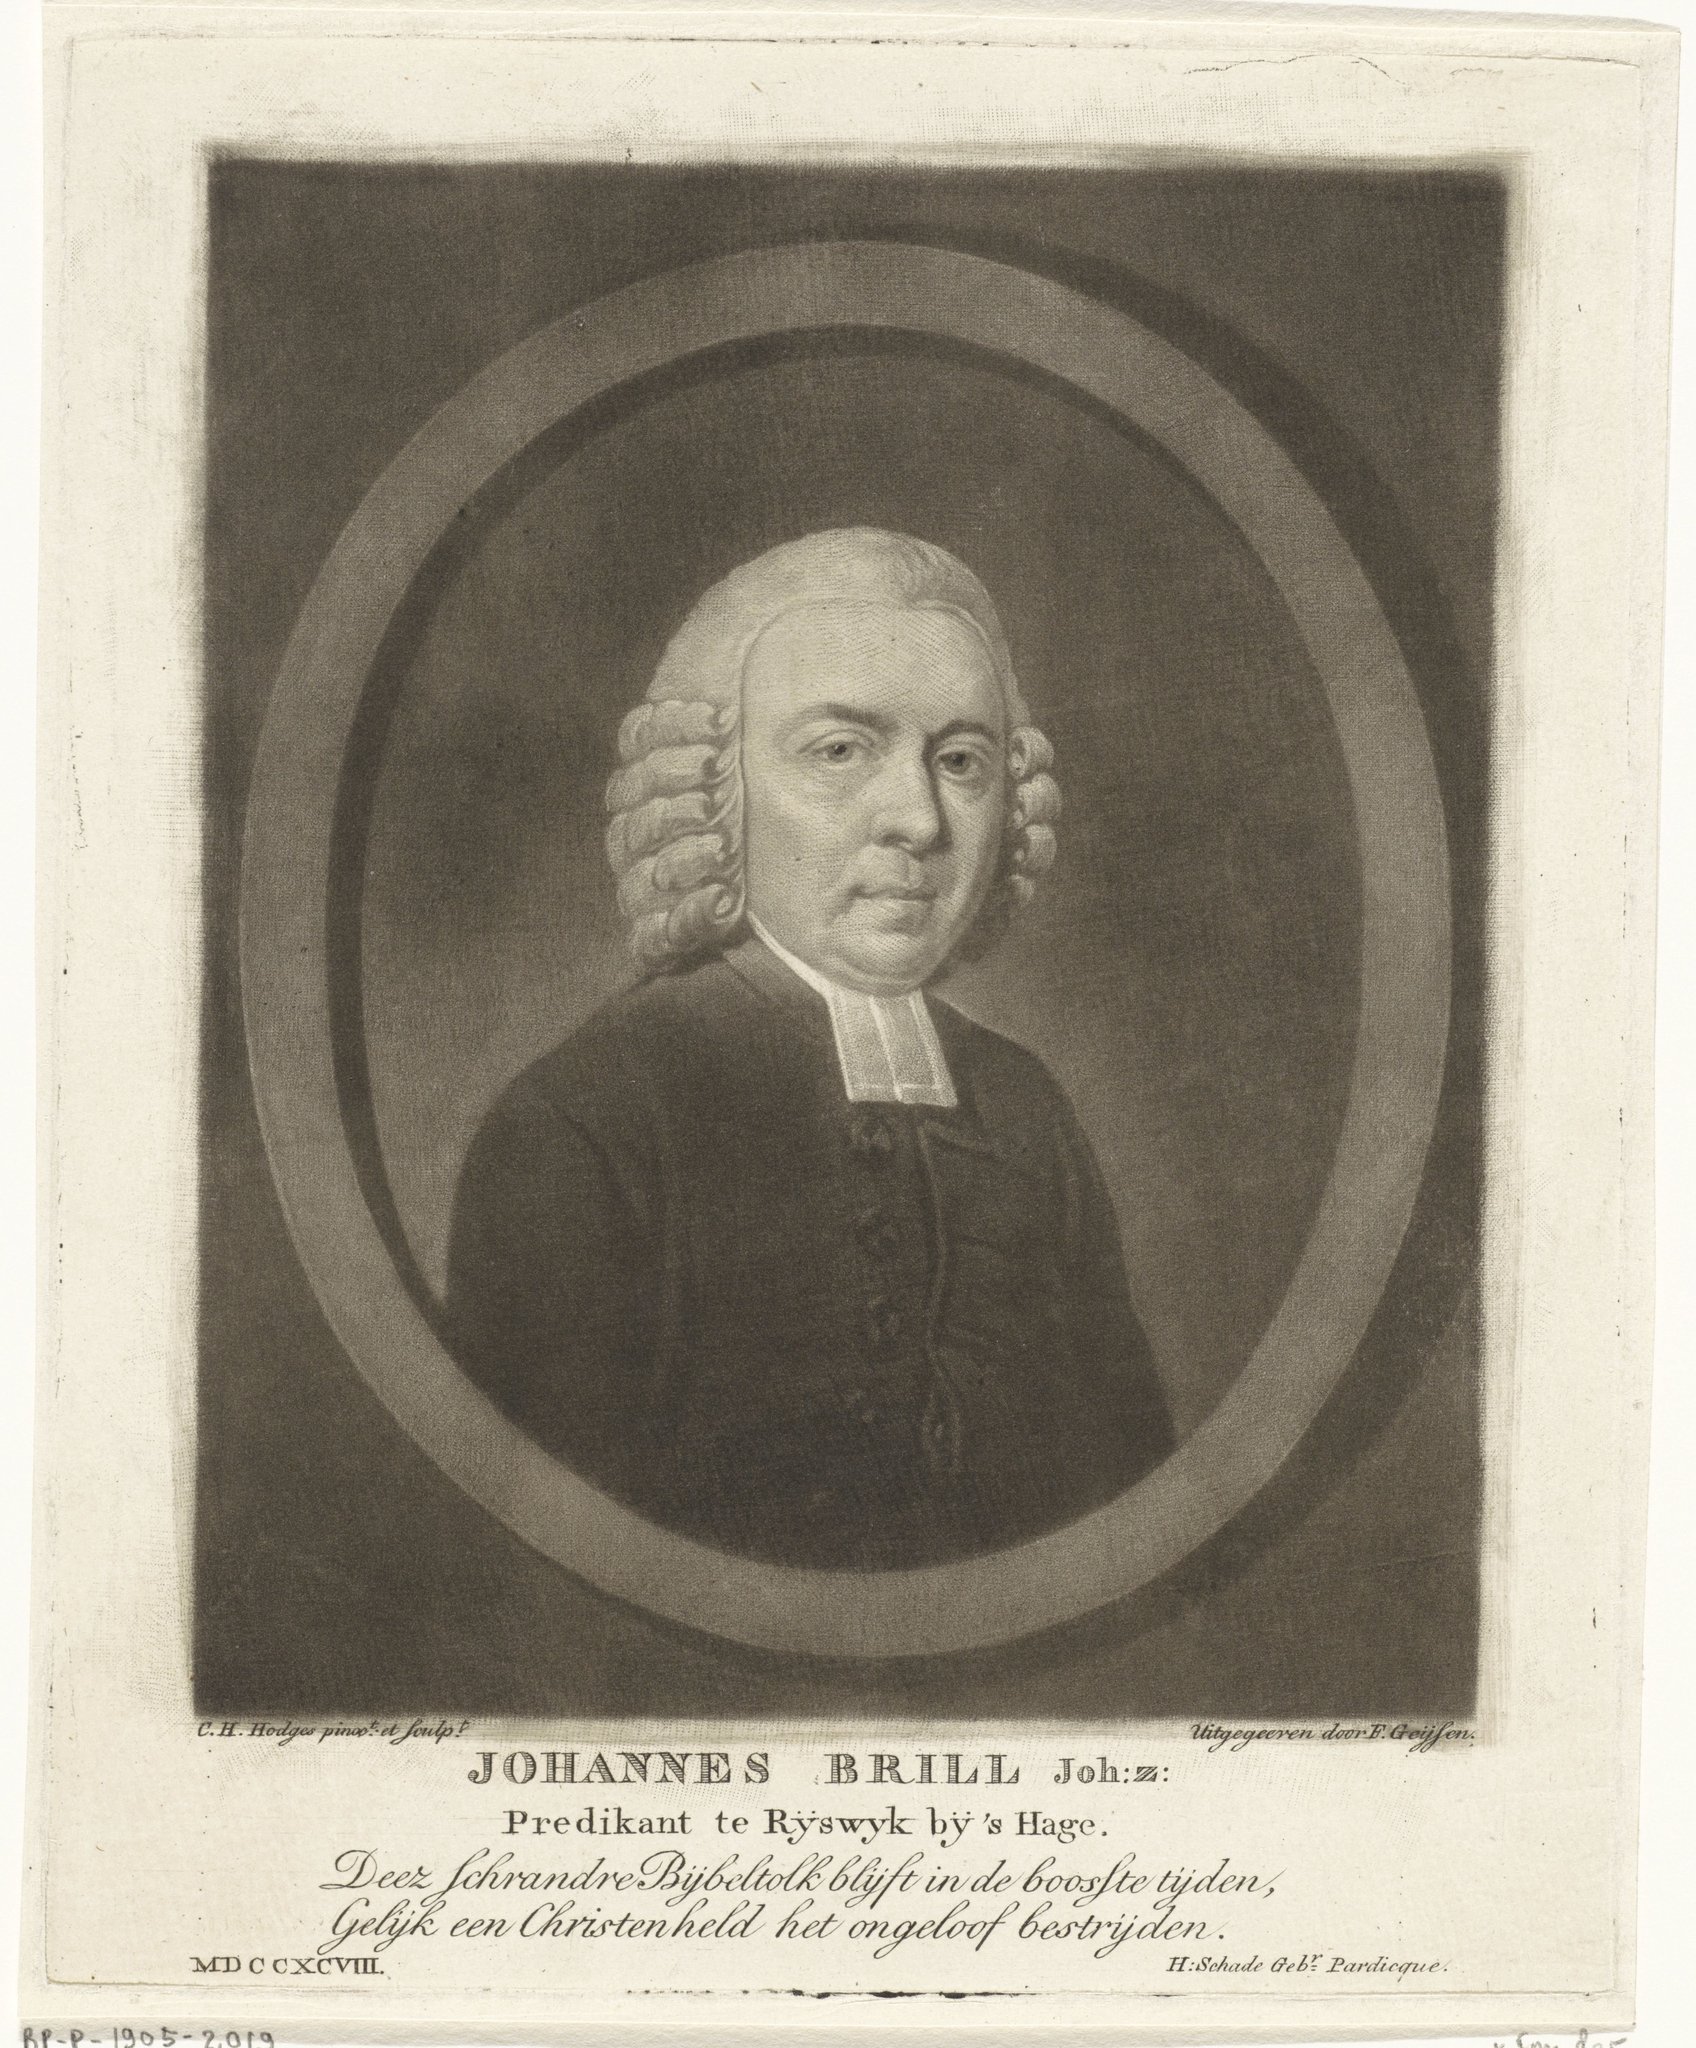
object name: print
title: Portret van de predikant Johannes Brill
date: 1798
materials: paper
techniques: engraving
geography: amsterdam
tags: wig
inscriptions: collector's mark: Lugt 2228